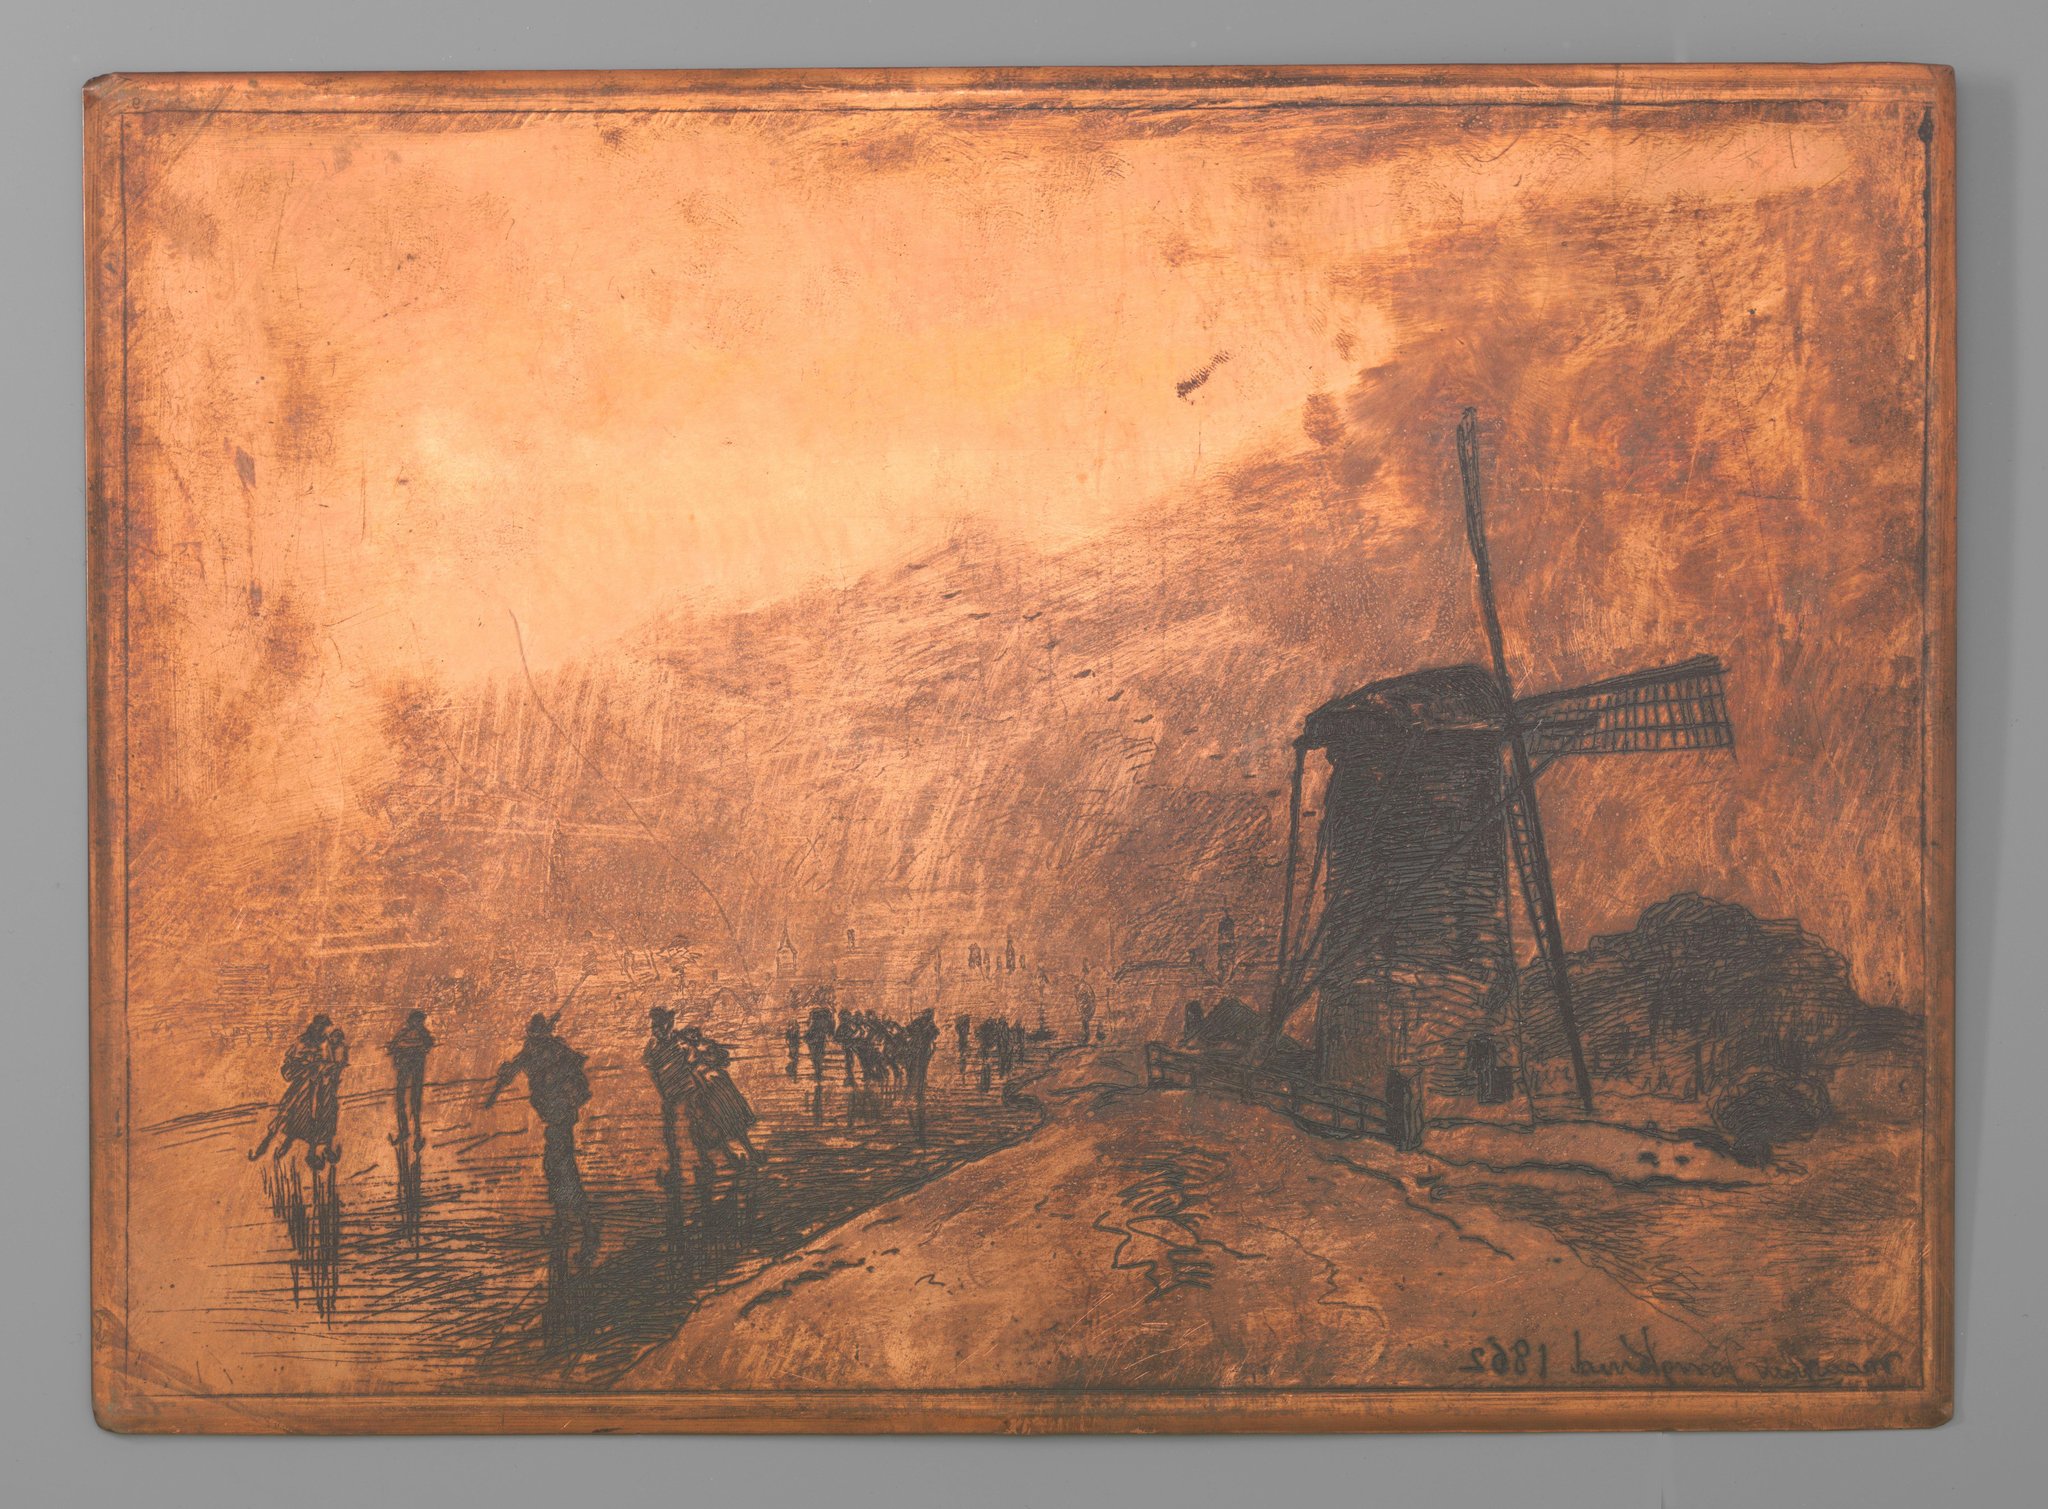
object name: copper plate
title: Gezicht op Maassluis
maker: johan barthold jongkind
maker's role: draughtsman, painter, print maker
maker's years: 1819-1891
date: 1862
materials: copper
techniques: etching